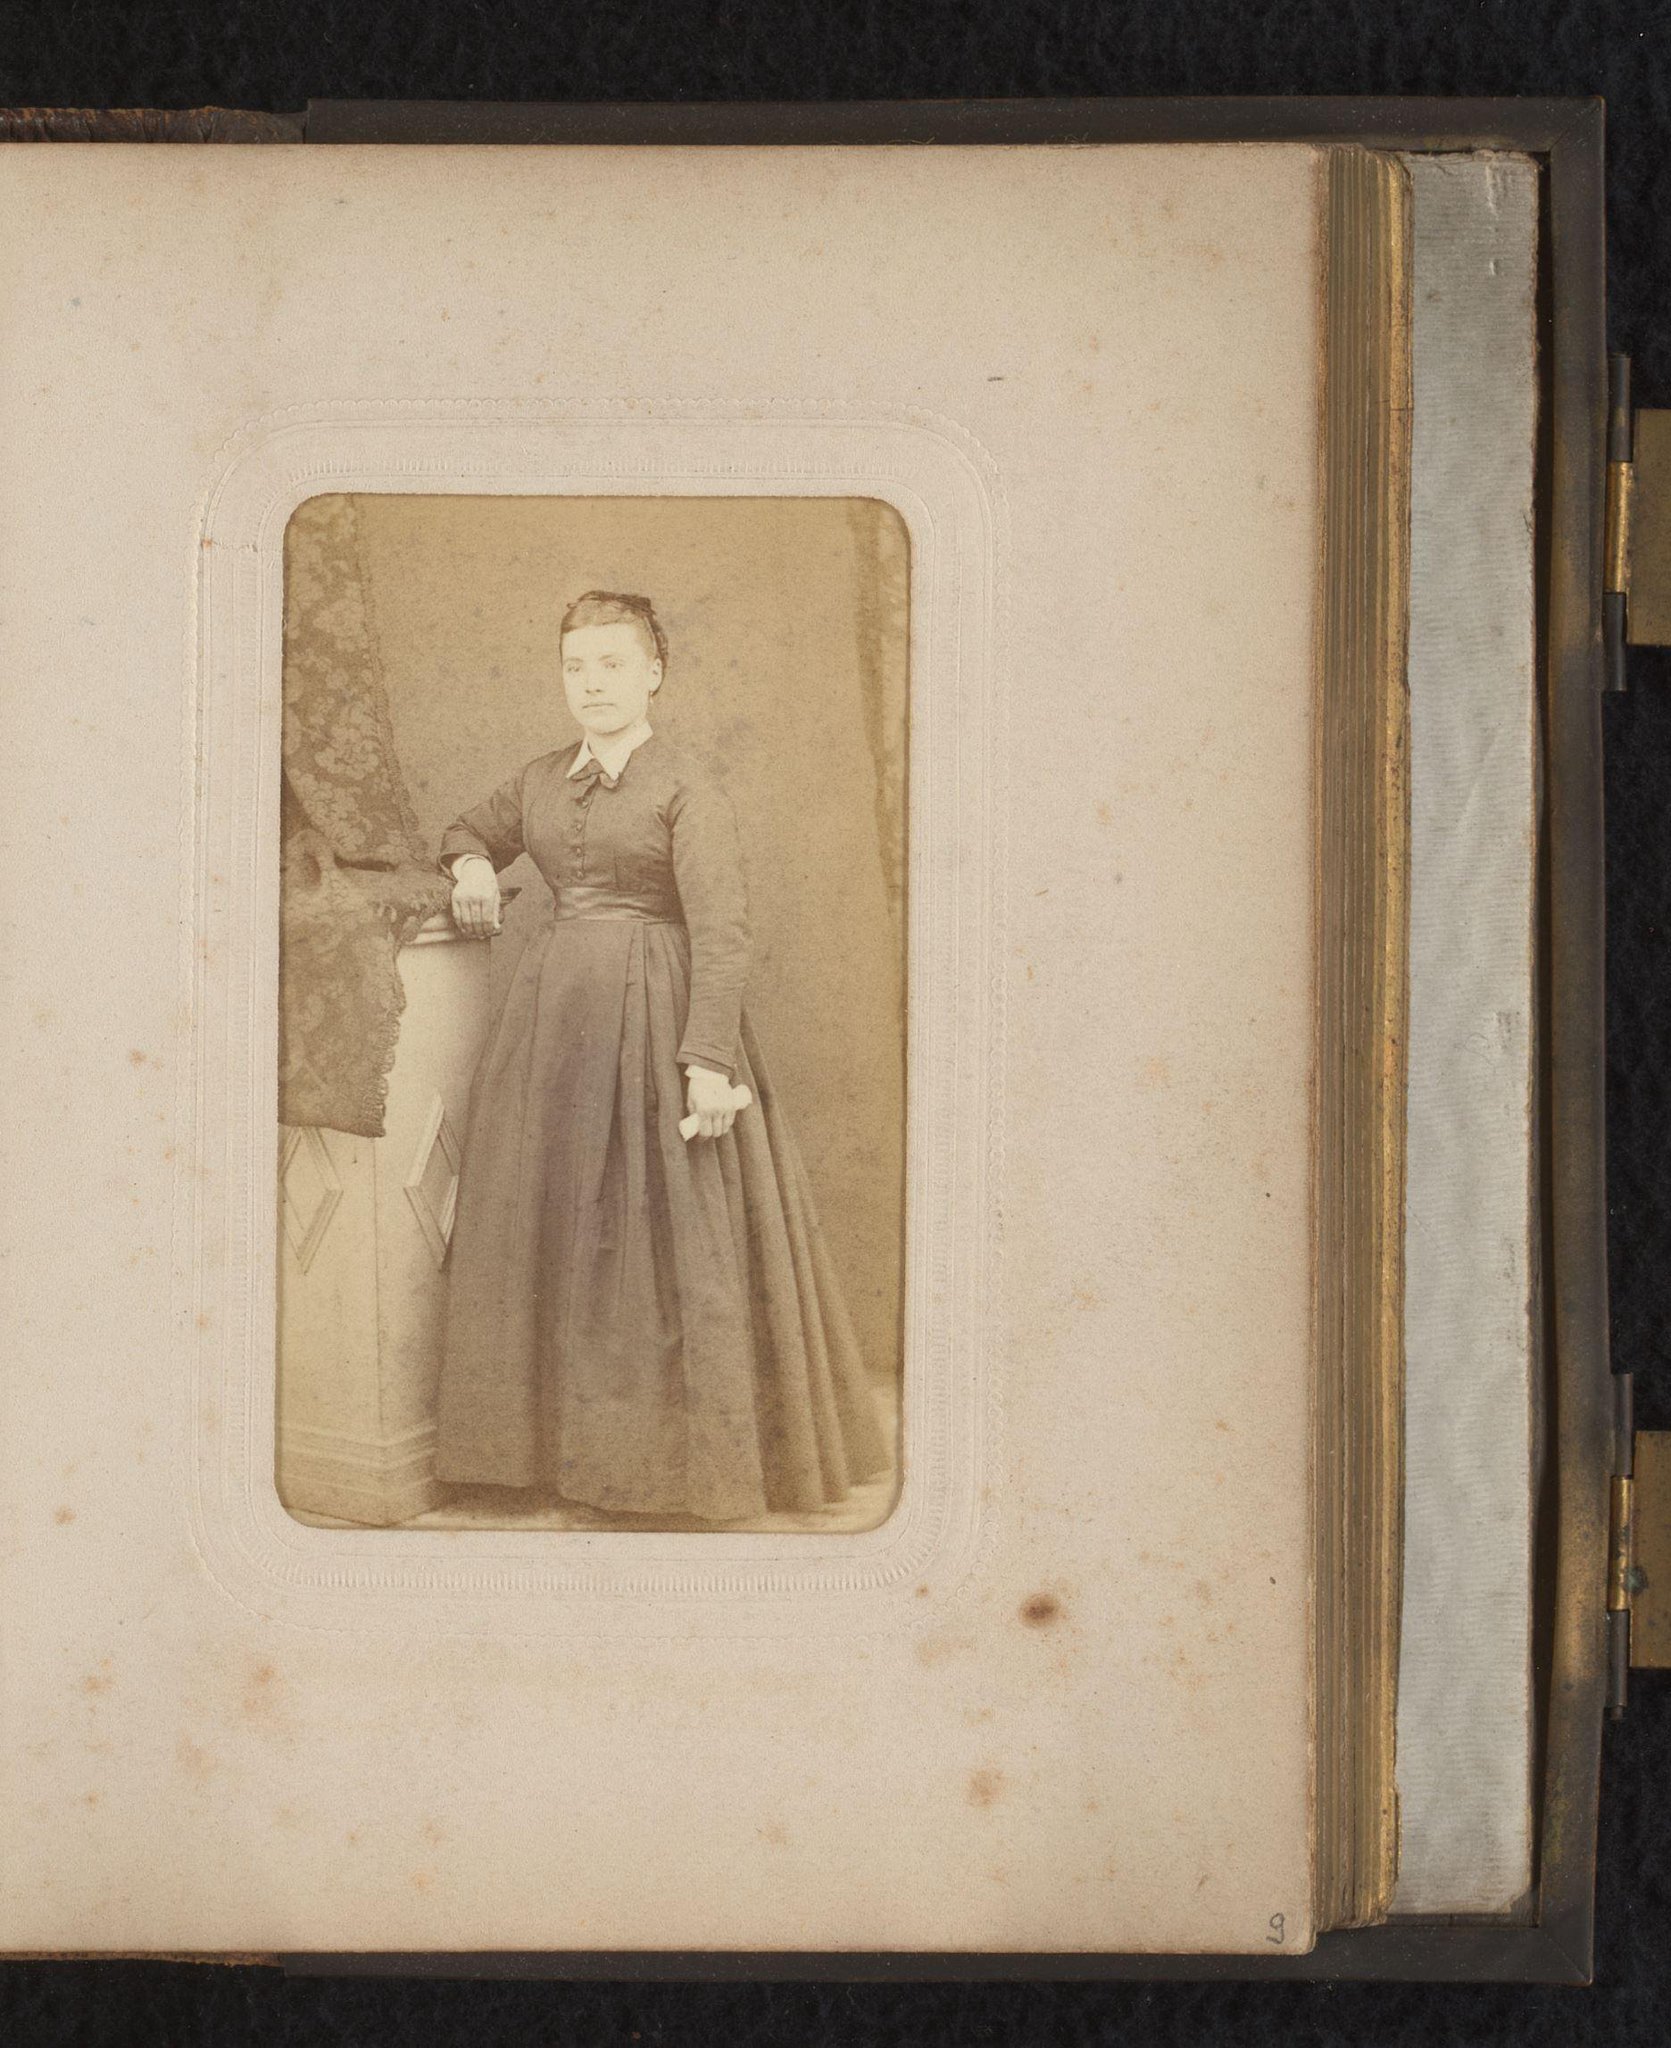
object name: carte de visite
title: Portret van een staande vrouw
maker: Anonymous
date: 1860-1900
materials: cardboard, photographic support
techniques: albumen print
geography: france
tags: historical persons - bb - woman, standing figure - aa - female human figure